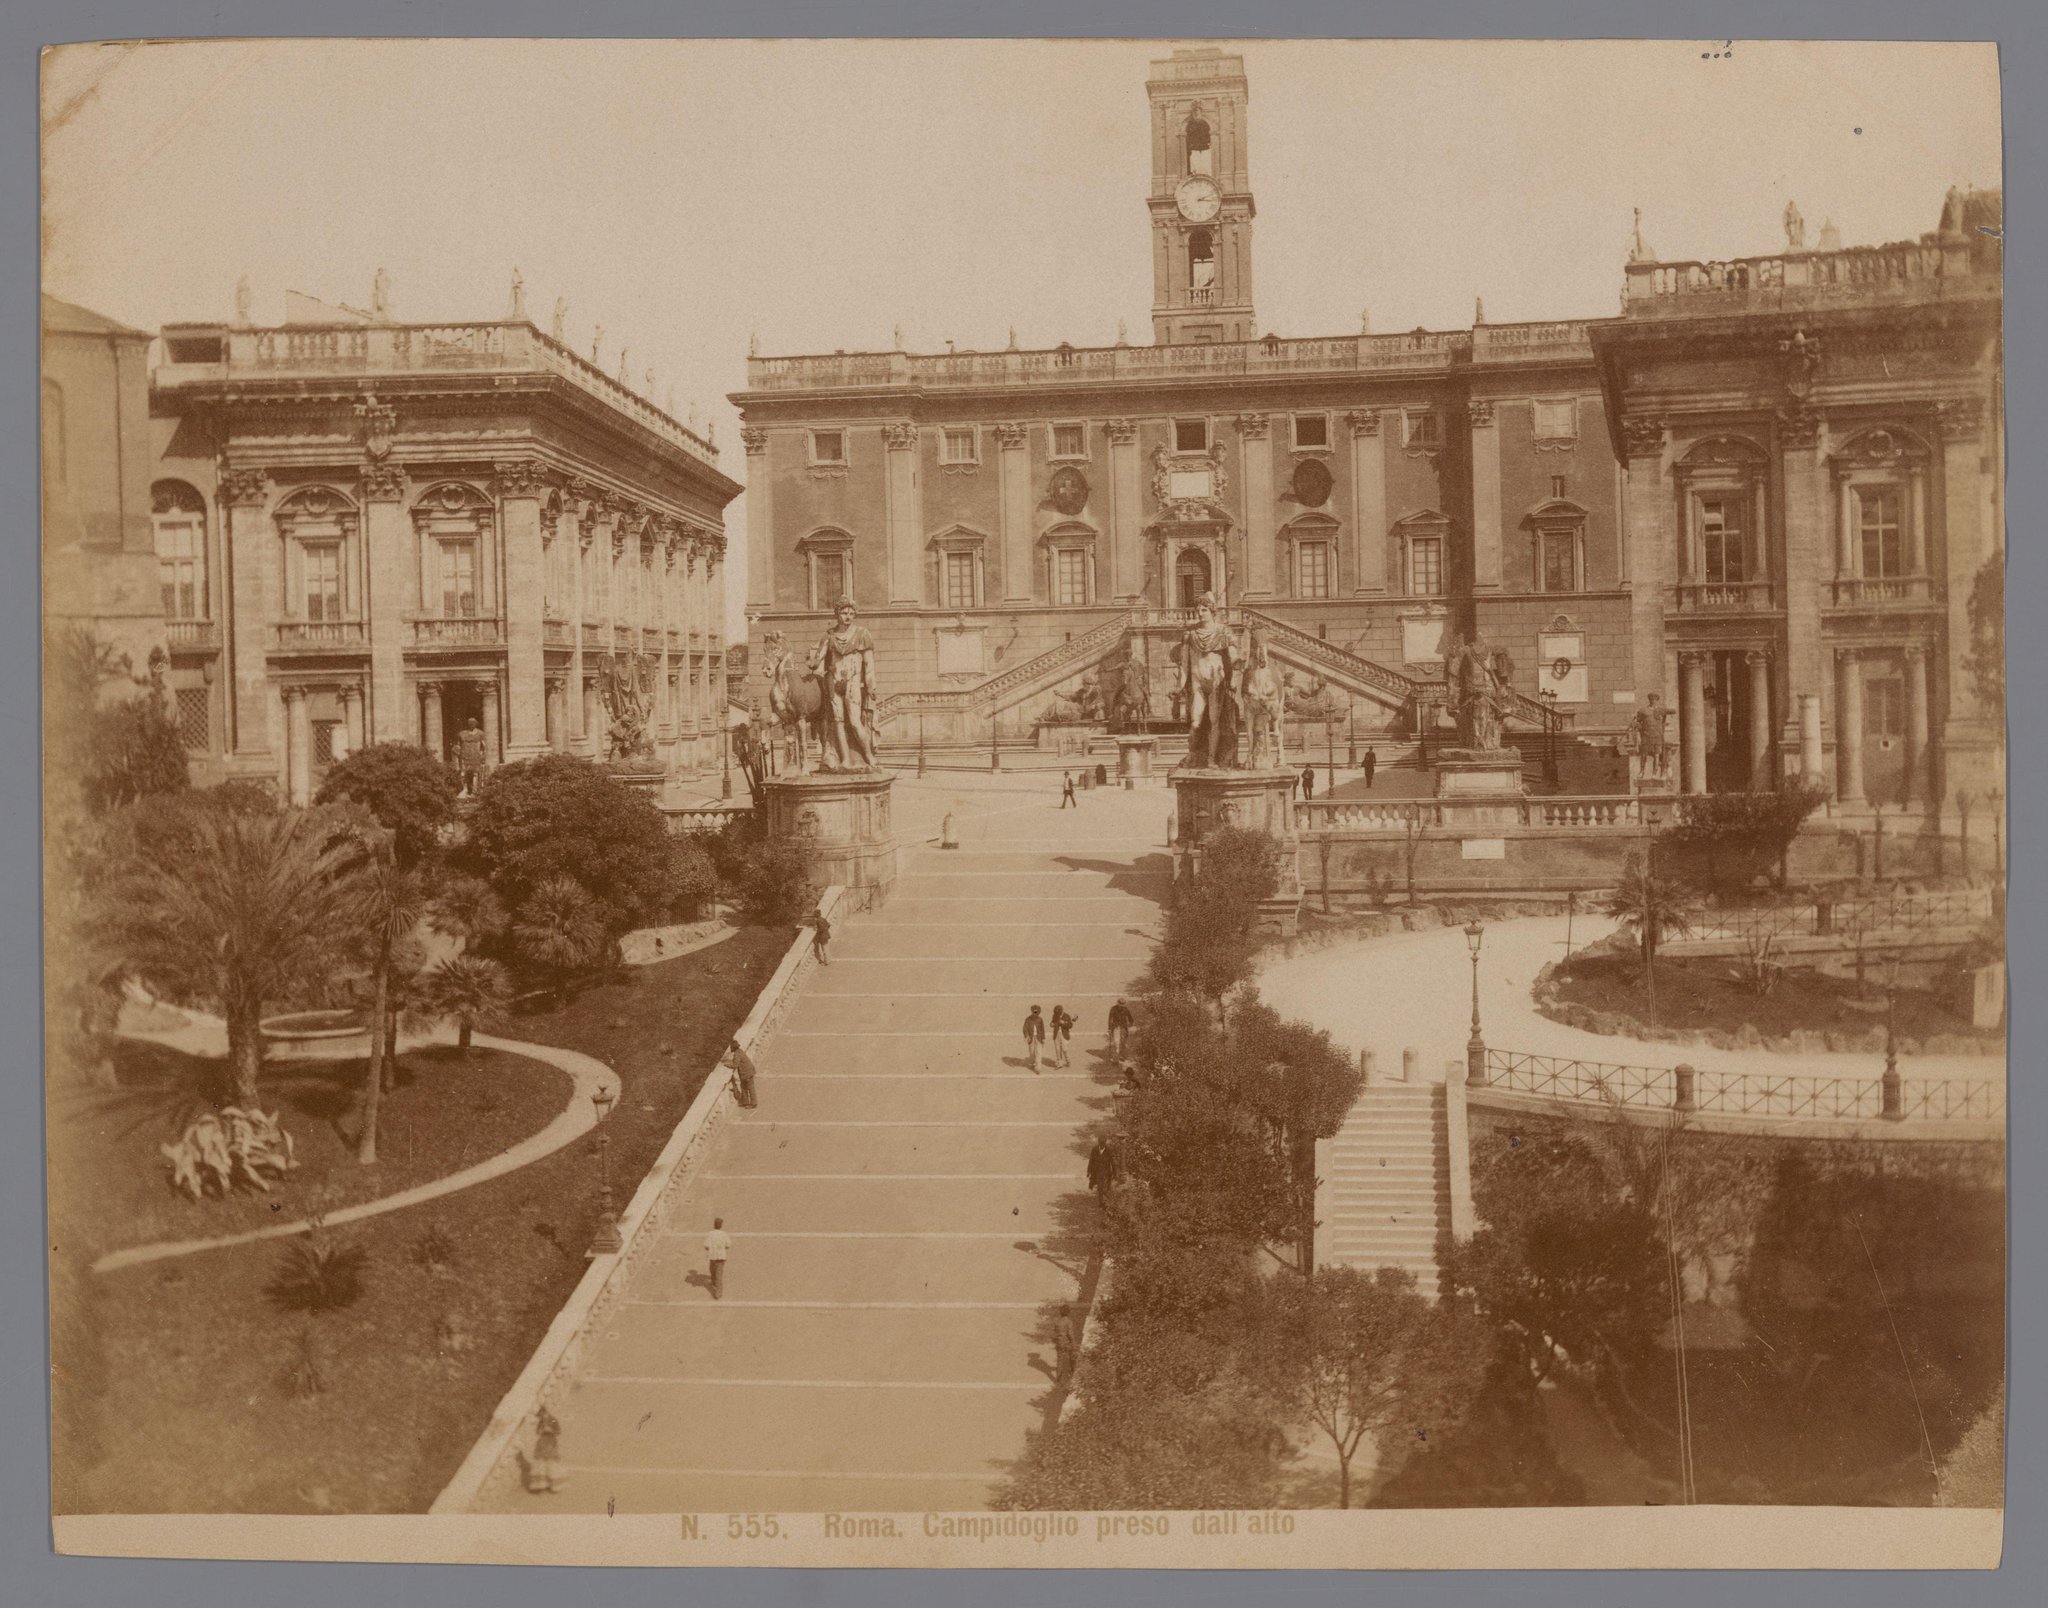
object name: photograph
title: Roma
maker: Anonymous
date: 1851-1900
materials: paper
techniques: albumen print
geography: rome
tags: square, place, circus, etc., staircase, exterior ~ representation of a building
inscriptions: number: ‘N. 555.’